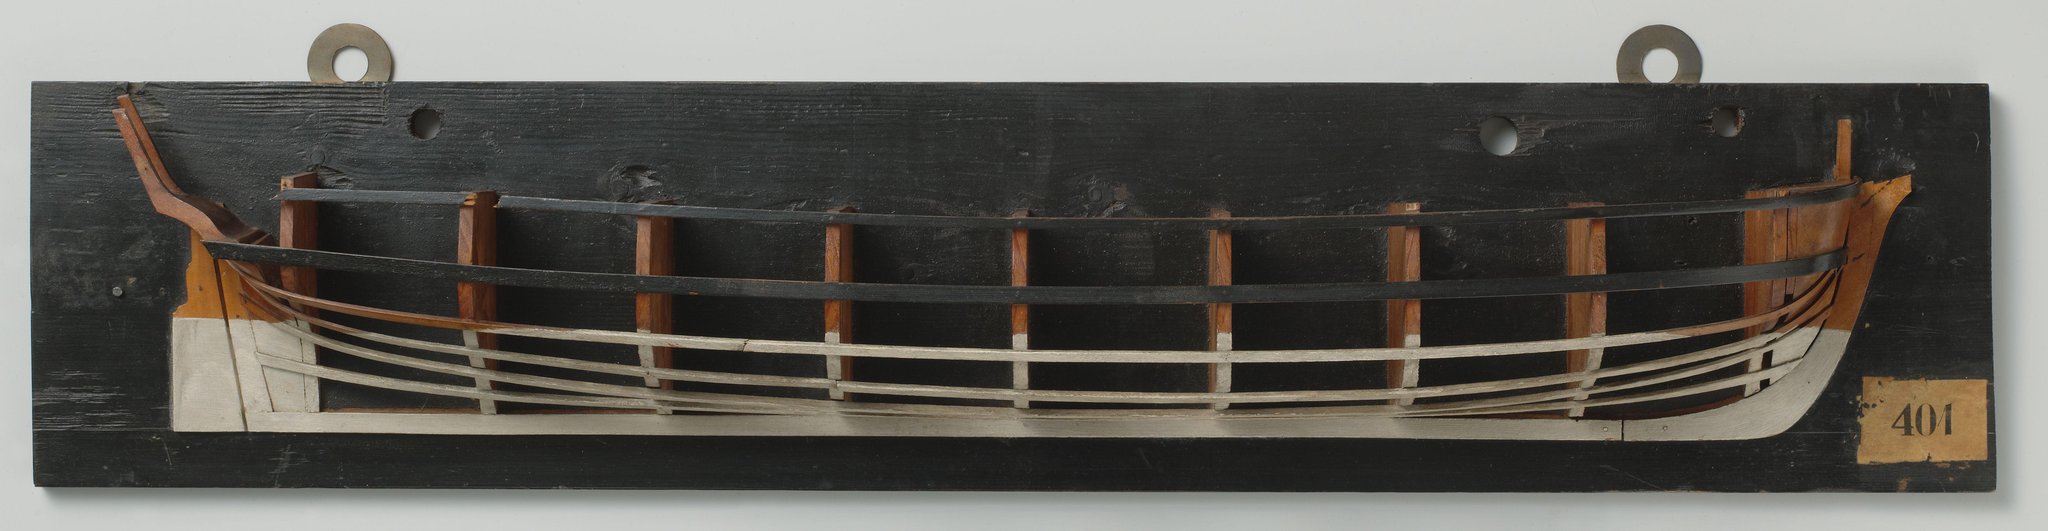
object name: half model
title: Half Model of a Schooner Gunboat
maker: Anonymous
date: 1780-1820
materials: wood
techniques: polychromy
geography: netherlands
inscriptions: label, bottom right: ‘401’ former inventory label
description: Gepolychromeerd mallenmodel (stuurboord). Gewrongen spiegel, hol wulf, geen details van het hek, geen zijgalerij; recht roer met vierkante roerkoning. Zeeg naar beide einden oplopend, één barkhout en één reehout. Geen sporen van het tuig. Gepiekt rondspant.